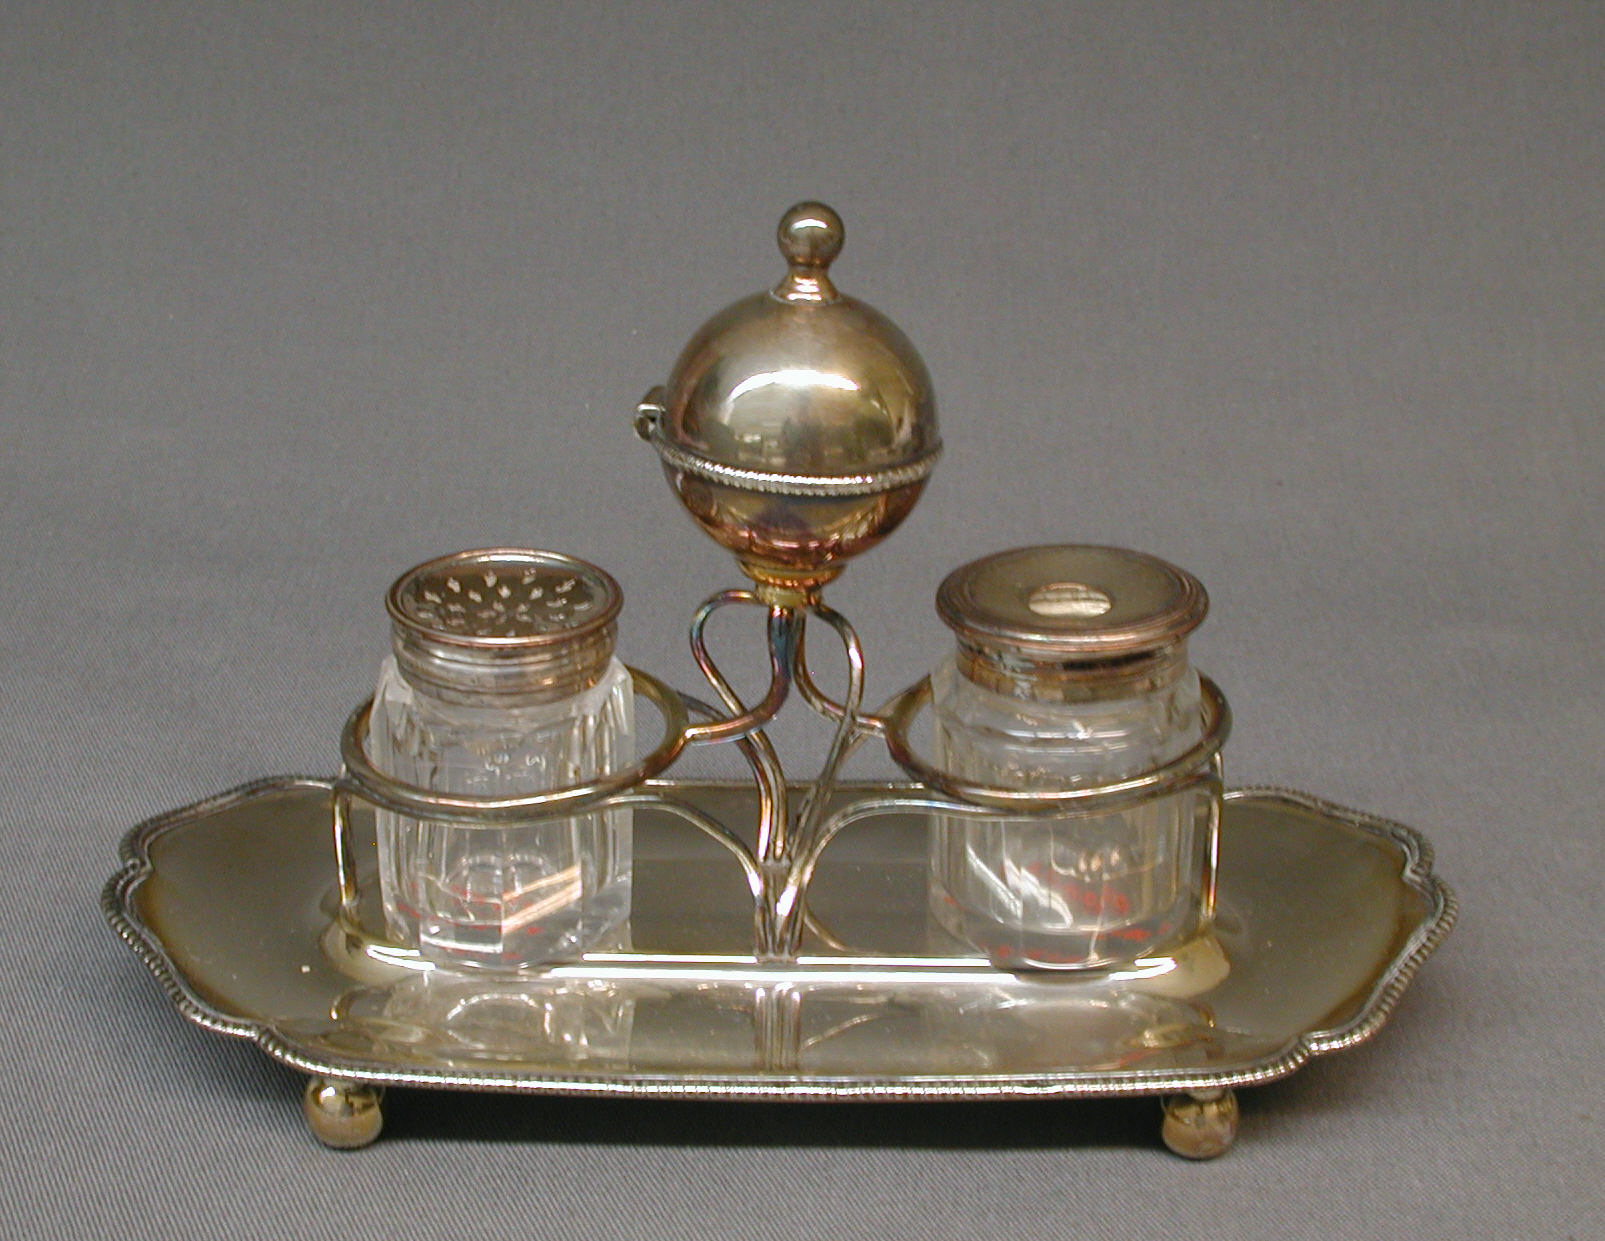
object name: inkstand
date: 1805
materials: glass, metal